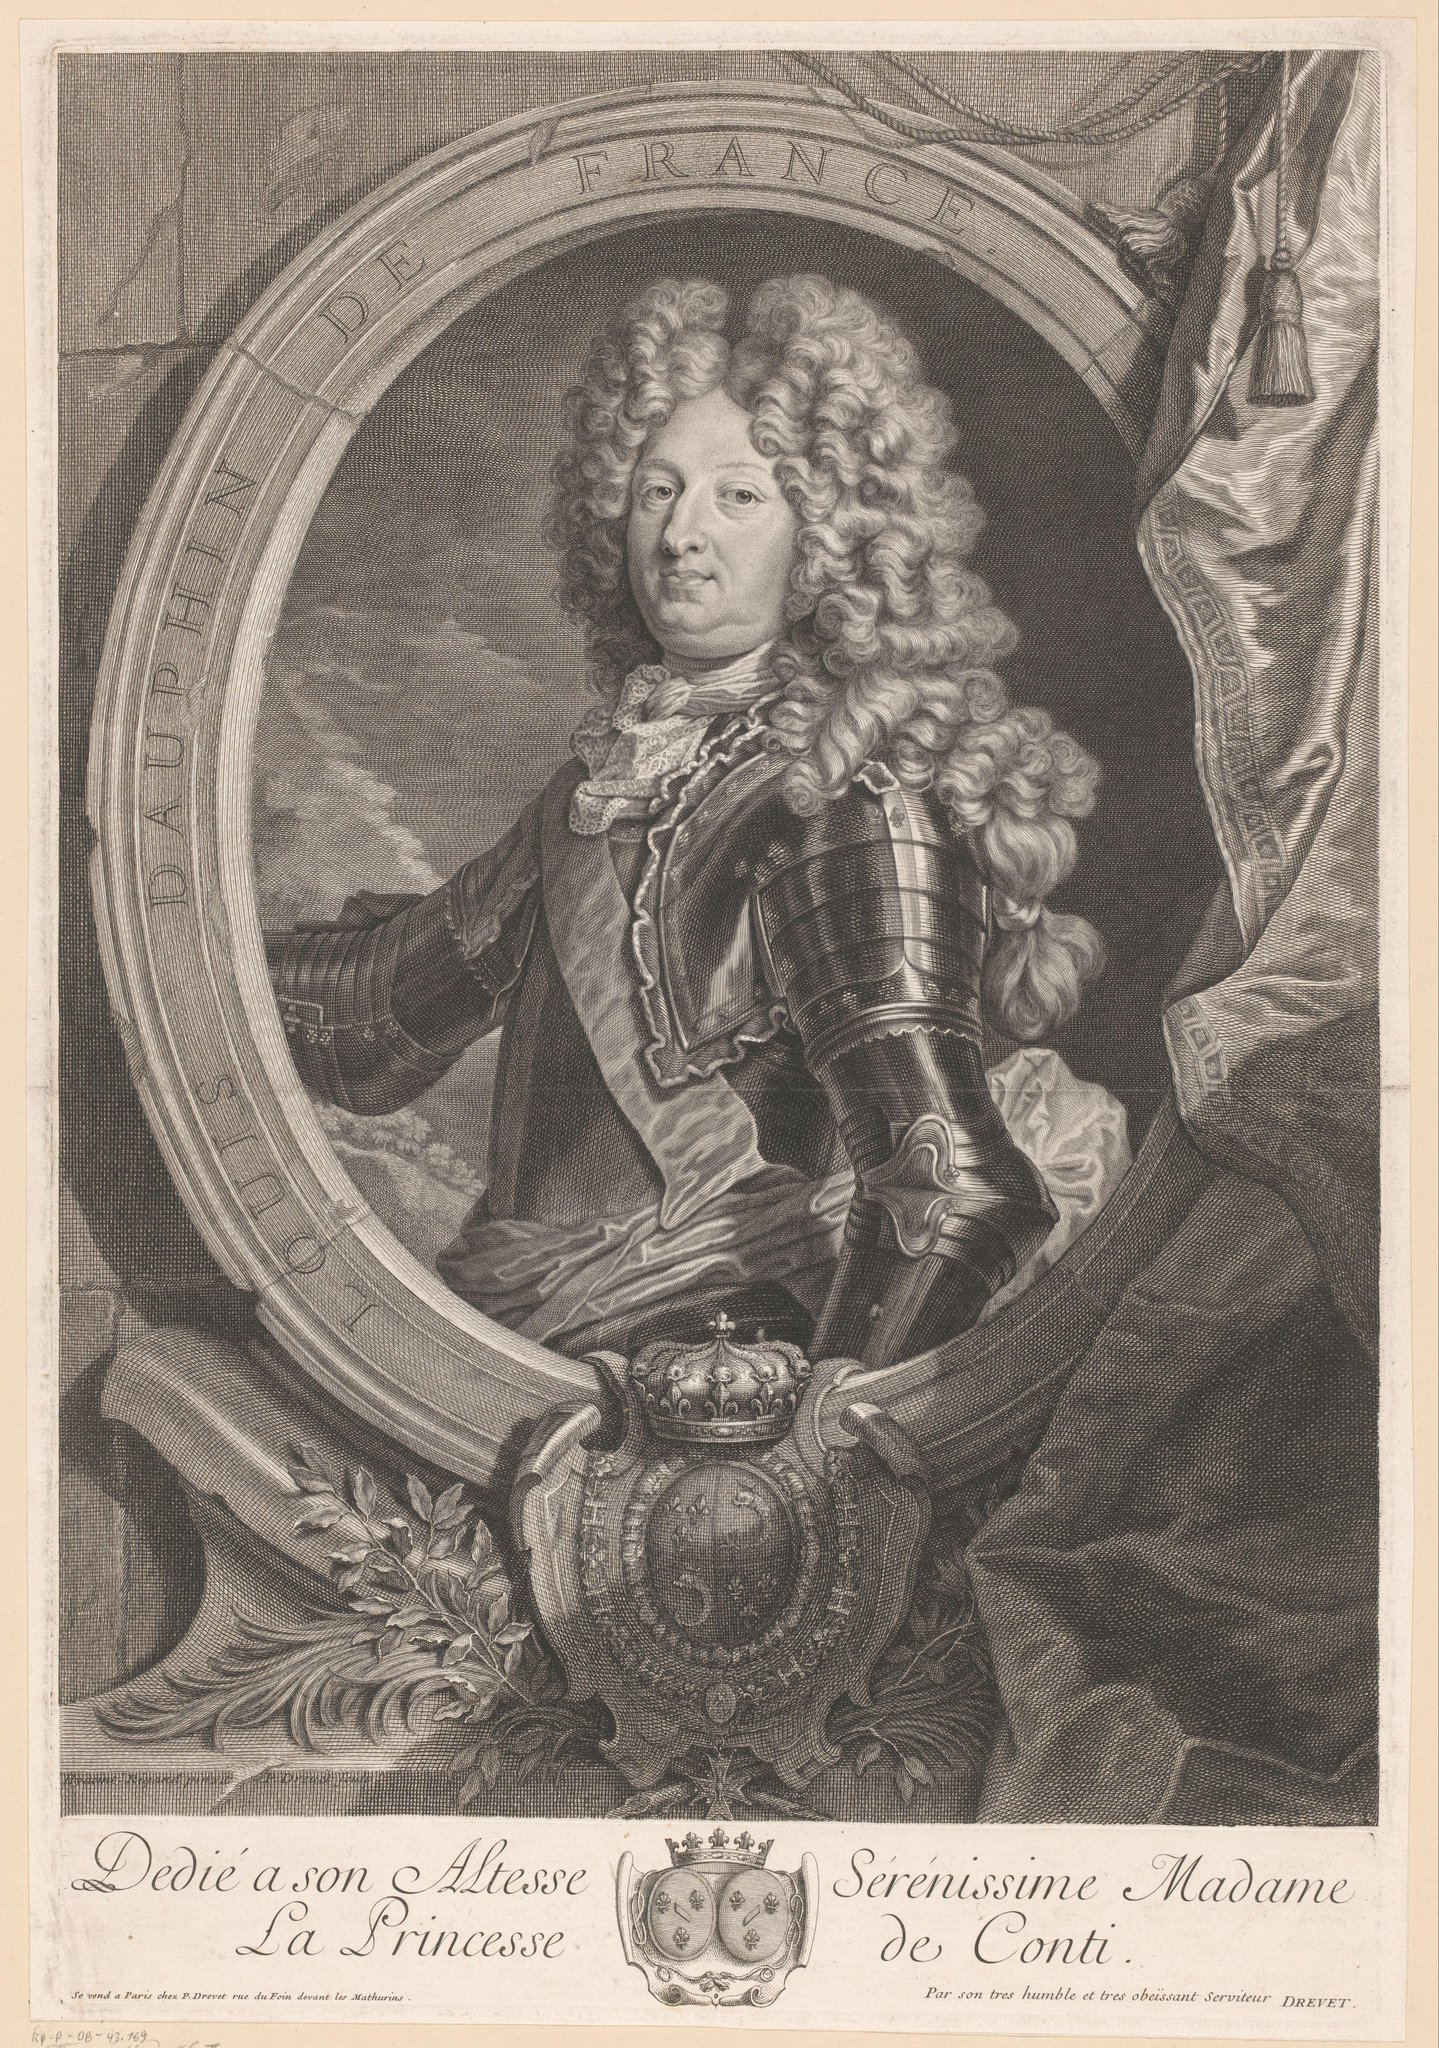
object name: print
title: Louis dauphin de France.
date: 1701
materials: paper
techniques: engraving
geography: paris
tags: dauphin van frankrijk lodewijk, ornament ~ medallion, historical persons, ruler, sovereign, armorial bearing, heraldry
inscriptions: collector's mark: Lugt 240